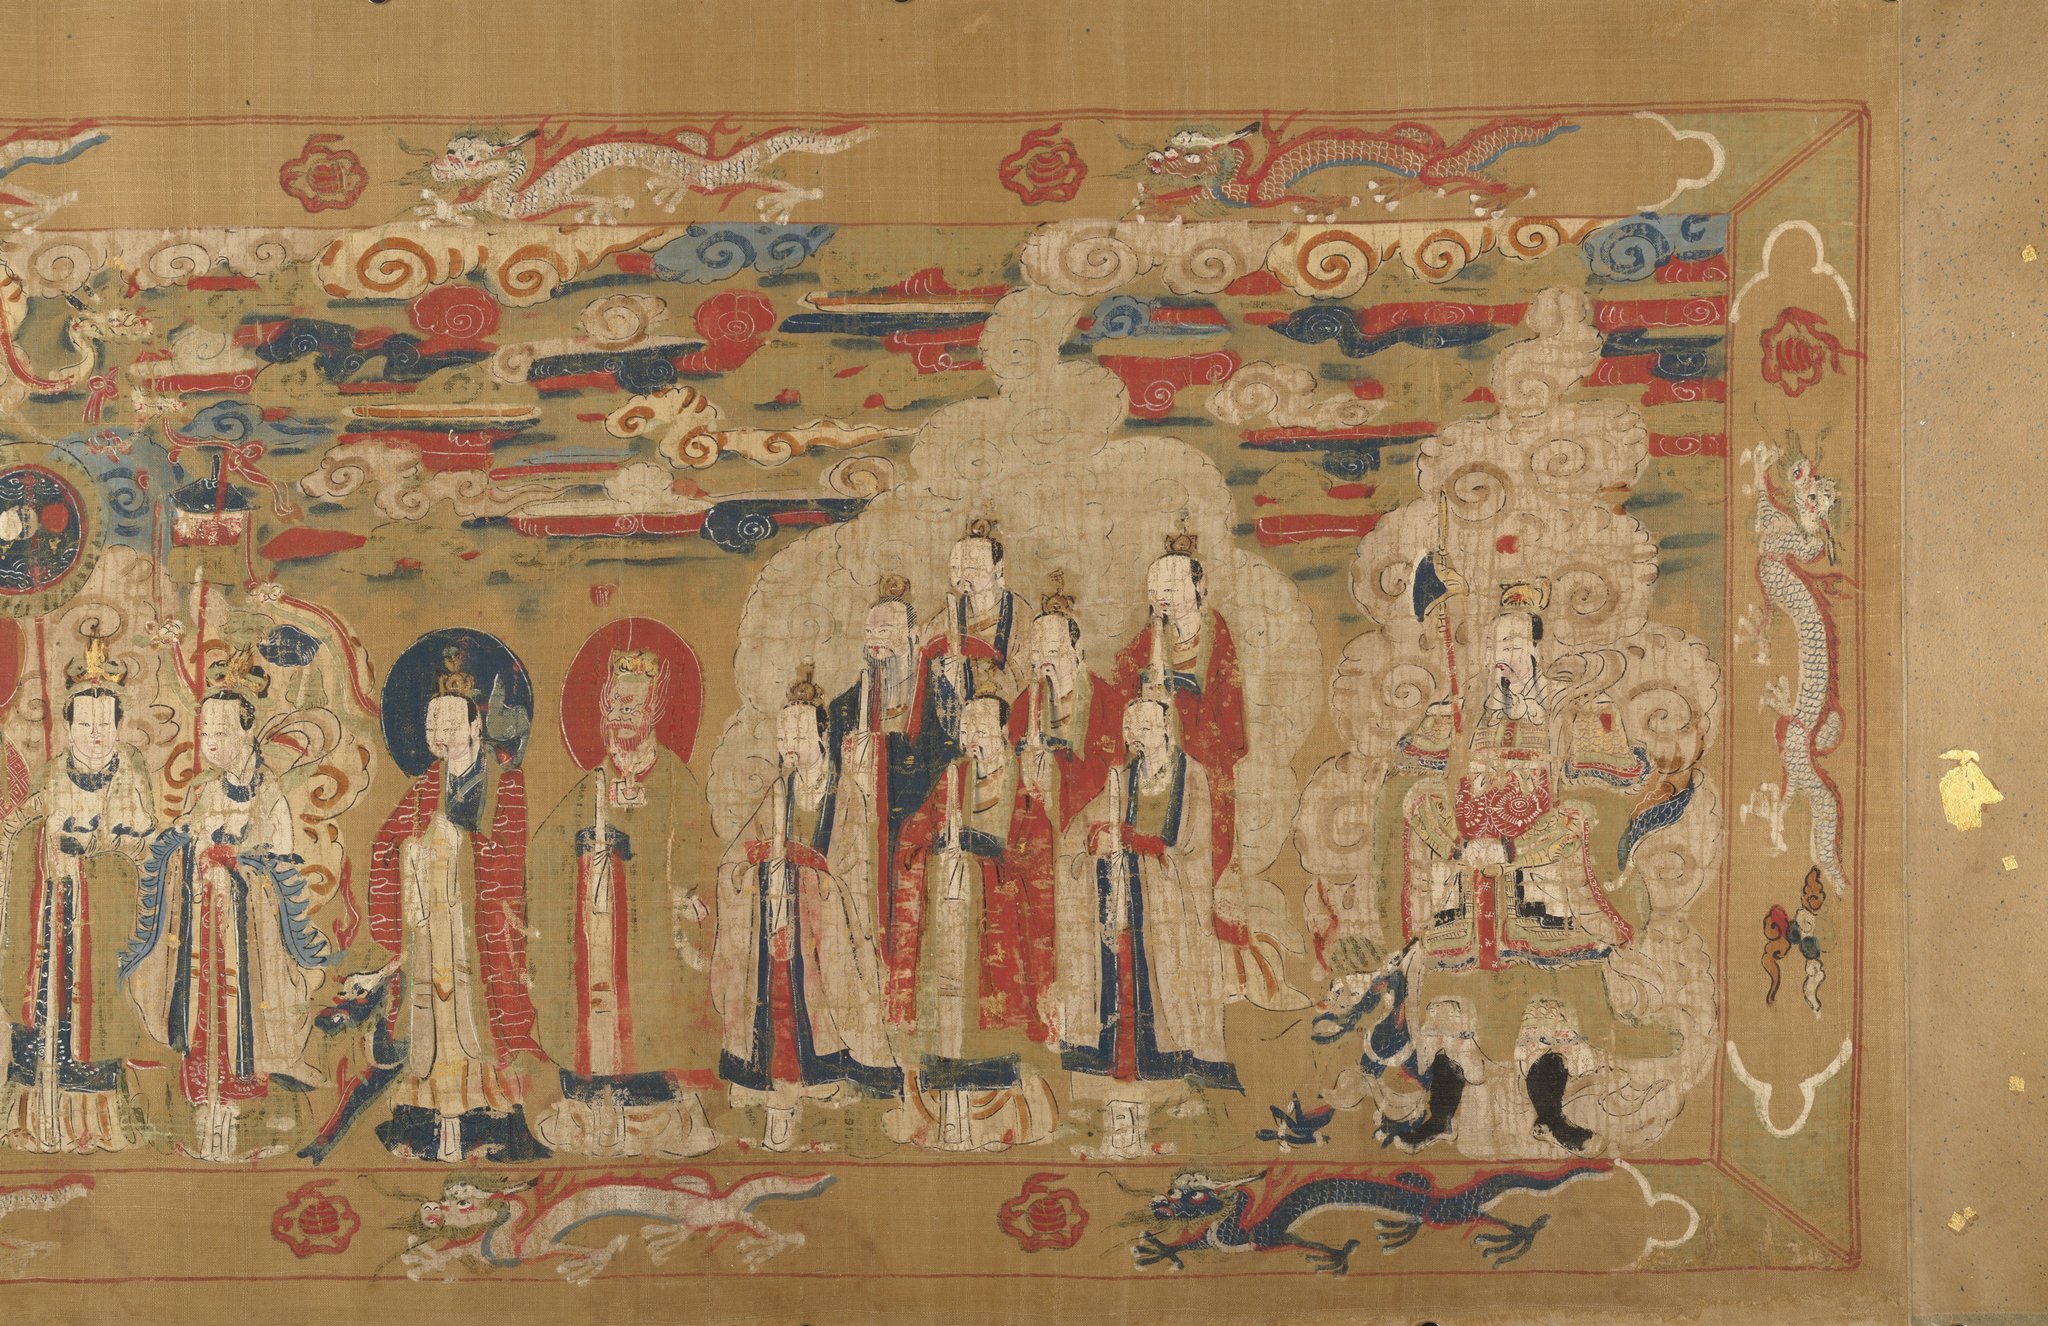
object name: handscroll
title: Canonization scroll of Li Zhong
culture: chinese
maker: unidentified artist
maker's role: artist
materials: gold, ink, silk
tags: men,women,dragons,daoism